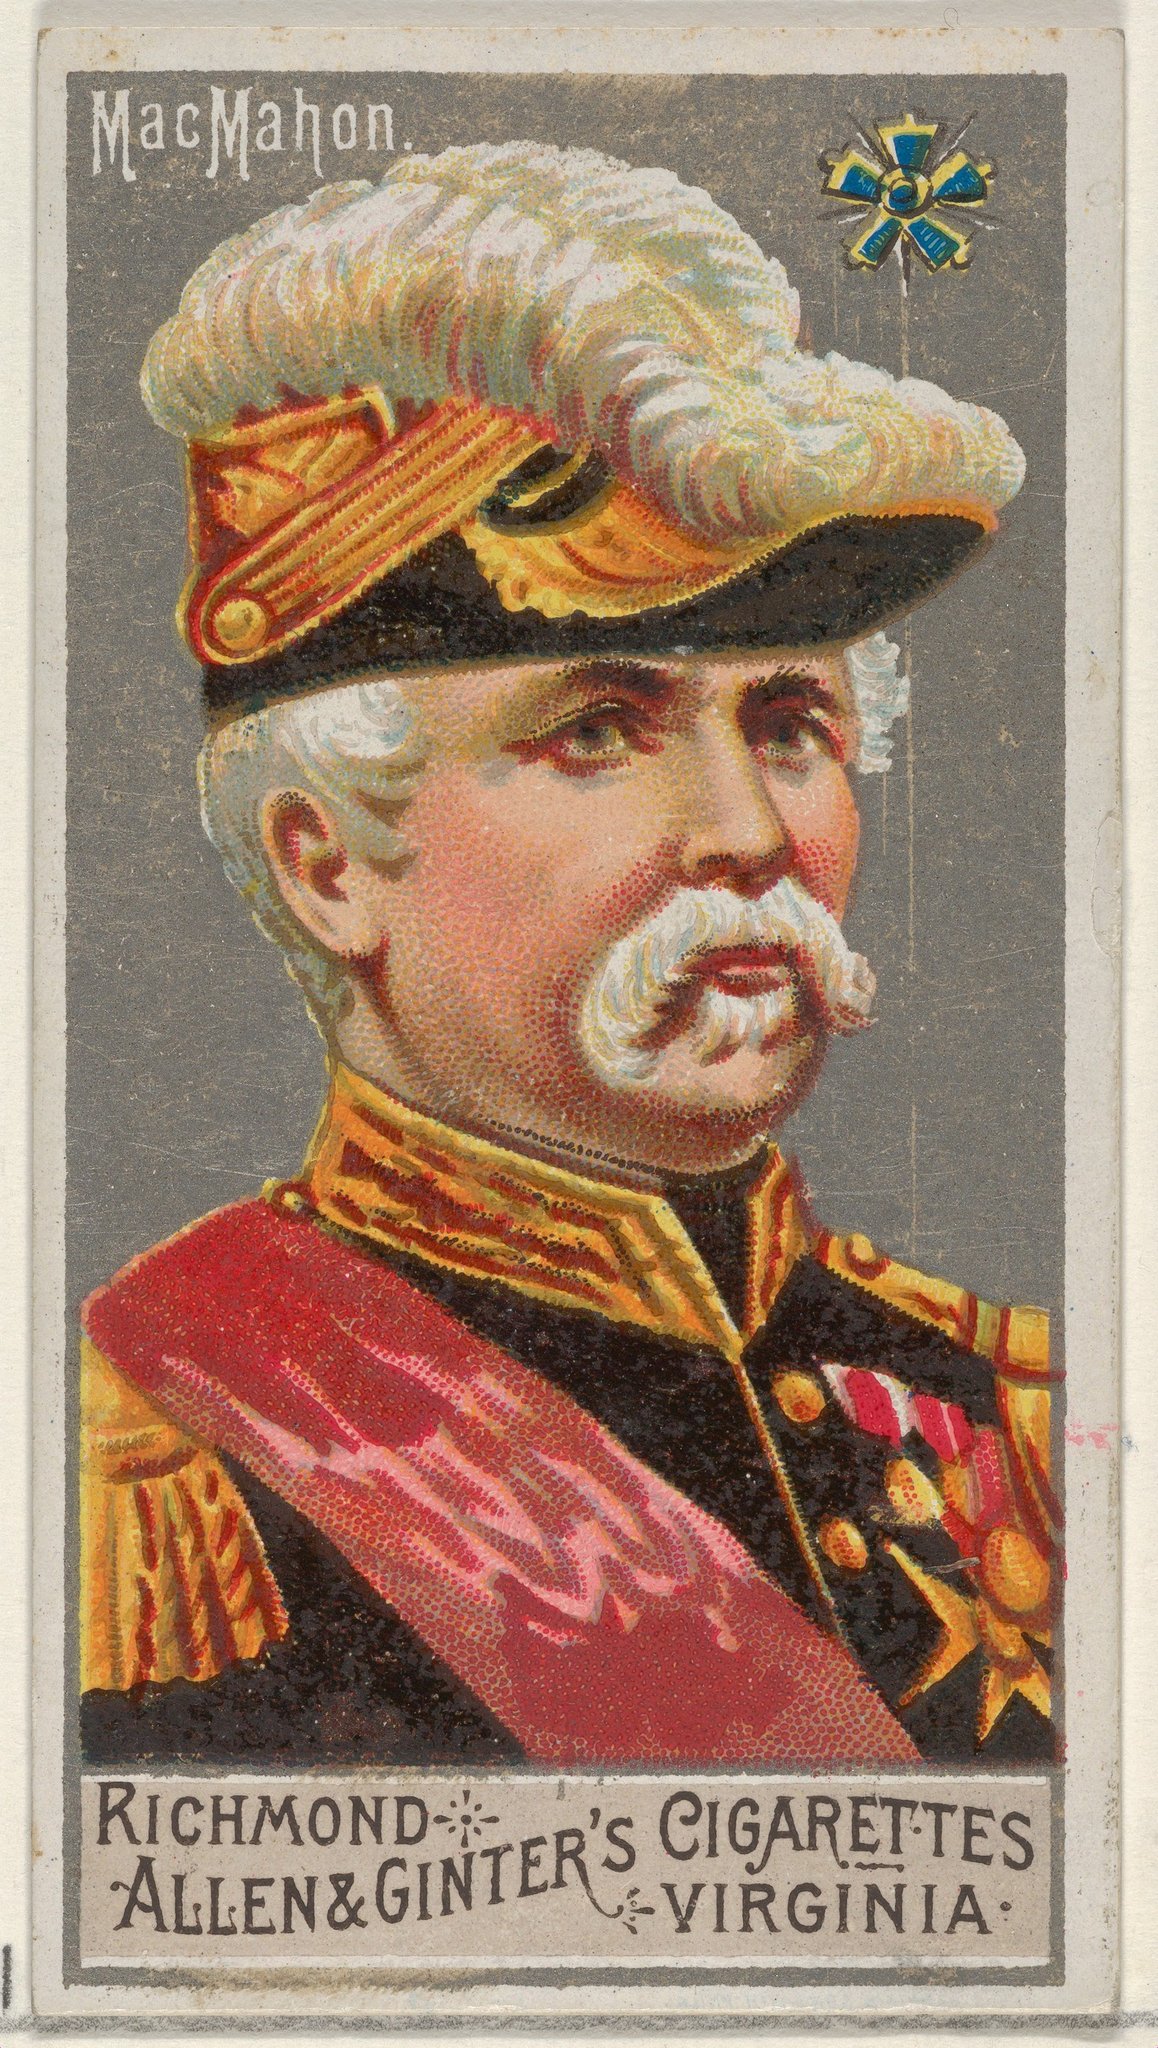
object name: print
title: MacMahon, from the Great Generals series (N15) for Allen & Ginter Cigarettes Brands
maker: allen & ginter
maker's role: publisher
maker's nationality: american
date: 1888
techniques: color lithograph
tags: historical figures,men,generals